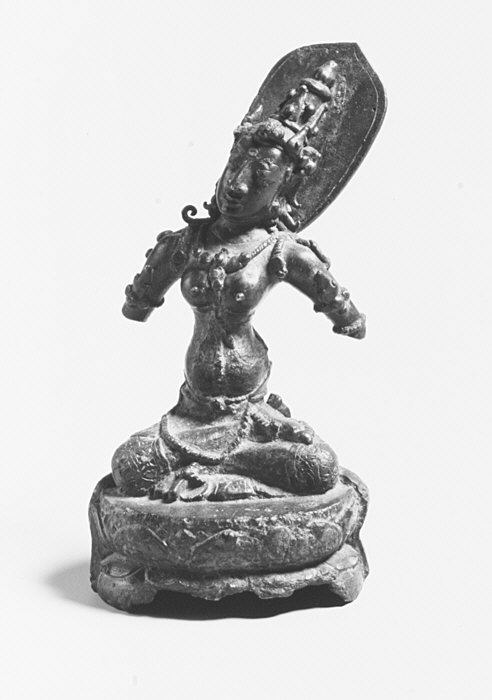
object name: figurine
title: Seated Female Deity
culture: indonesian, java, ngandjuk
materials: bronze